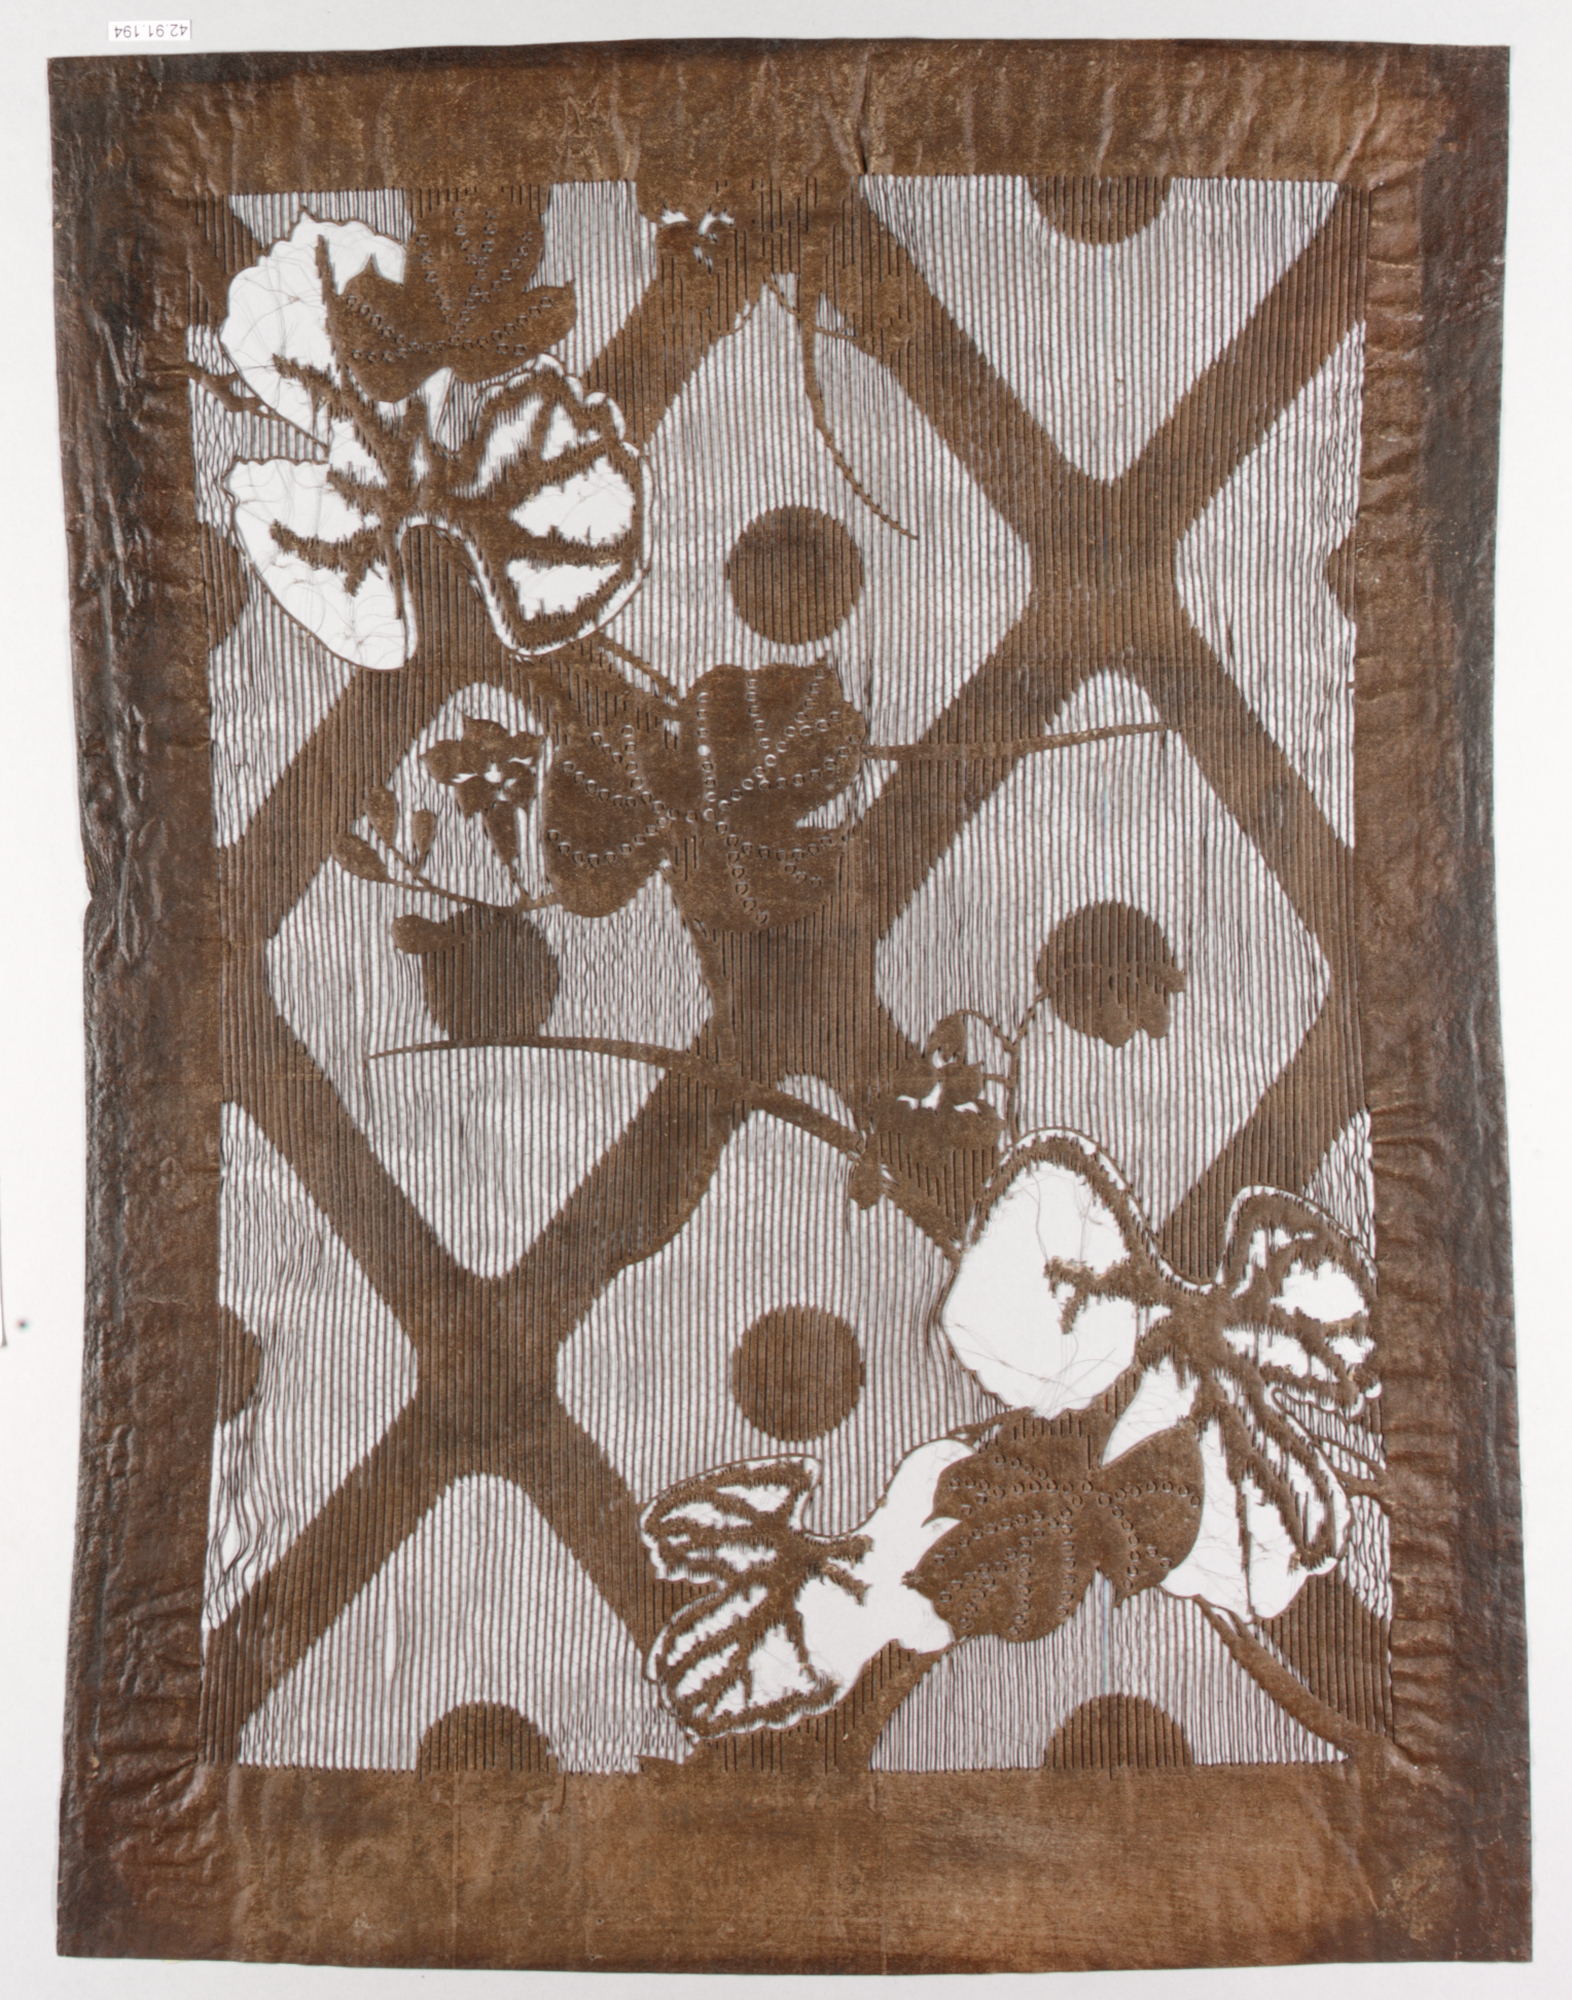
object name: stencil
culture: japanese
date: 1801-1900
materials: paper